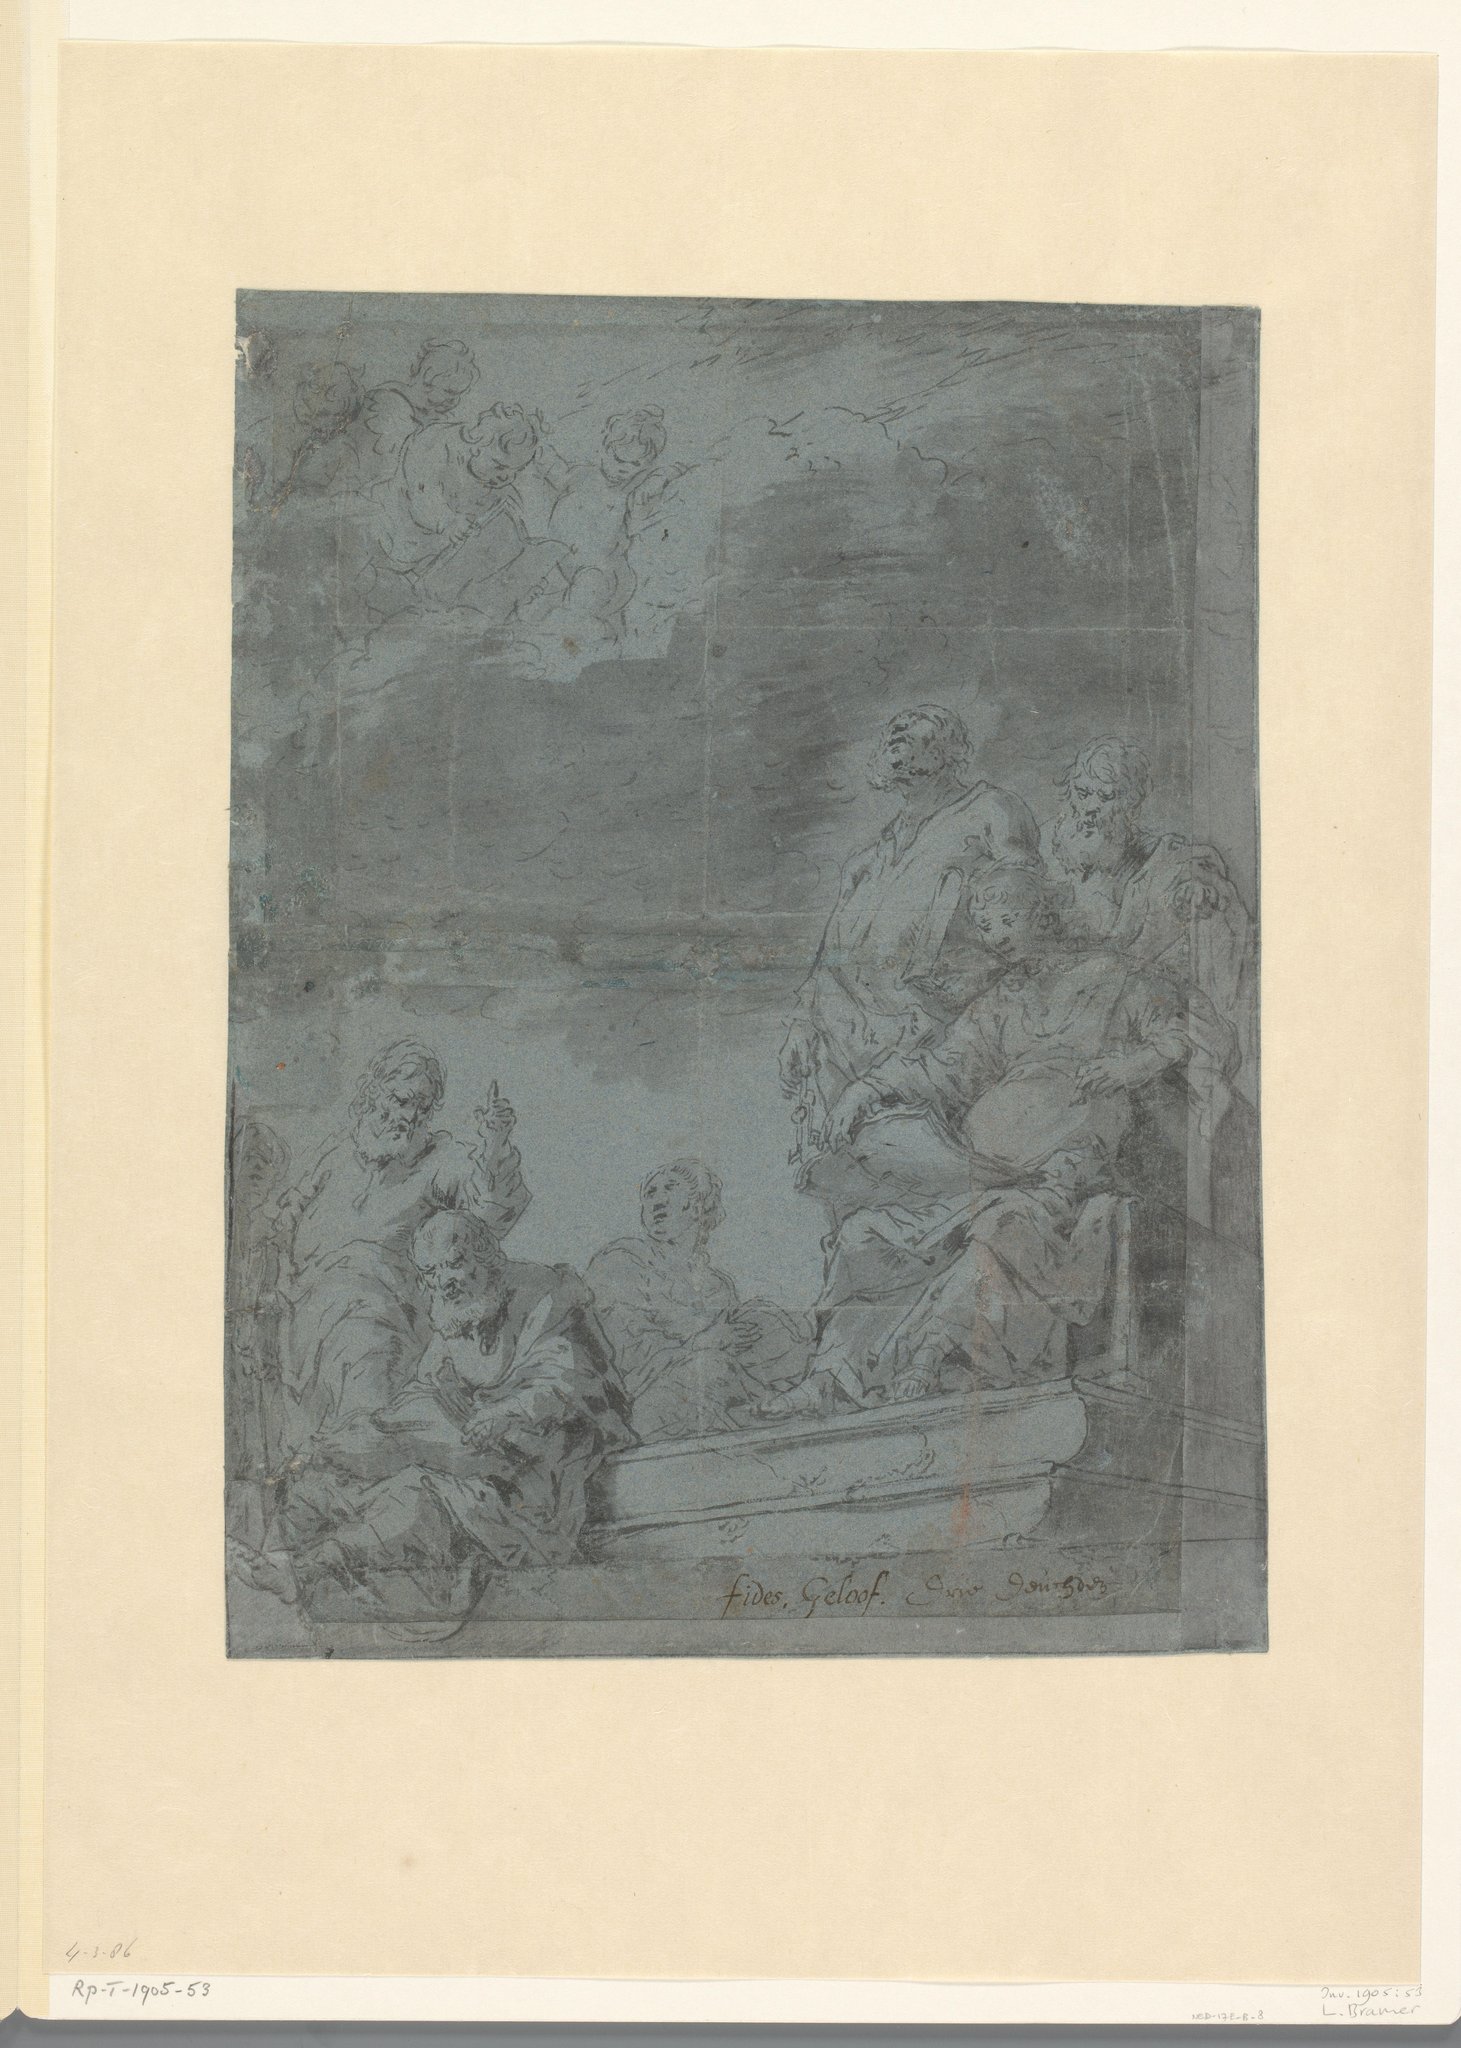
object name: drawing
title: Geloof (Fides)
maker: leonaert bramer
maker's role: draughtsman, painter, print maker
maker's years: 1596-1674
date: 1606-1674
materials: ink, paper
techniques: brush, pen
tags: faith, 'fides'; 'fede', 'fede catholica', 'fede christiana', 'fede christiana catholica' (ripa) ~ one of the three theological virtues